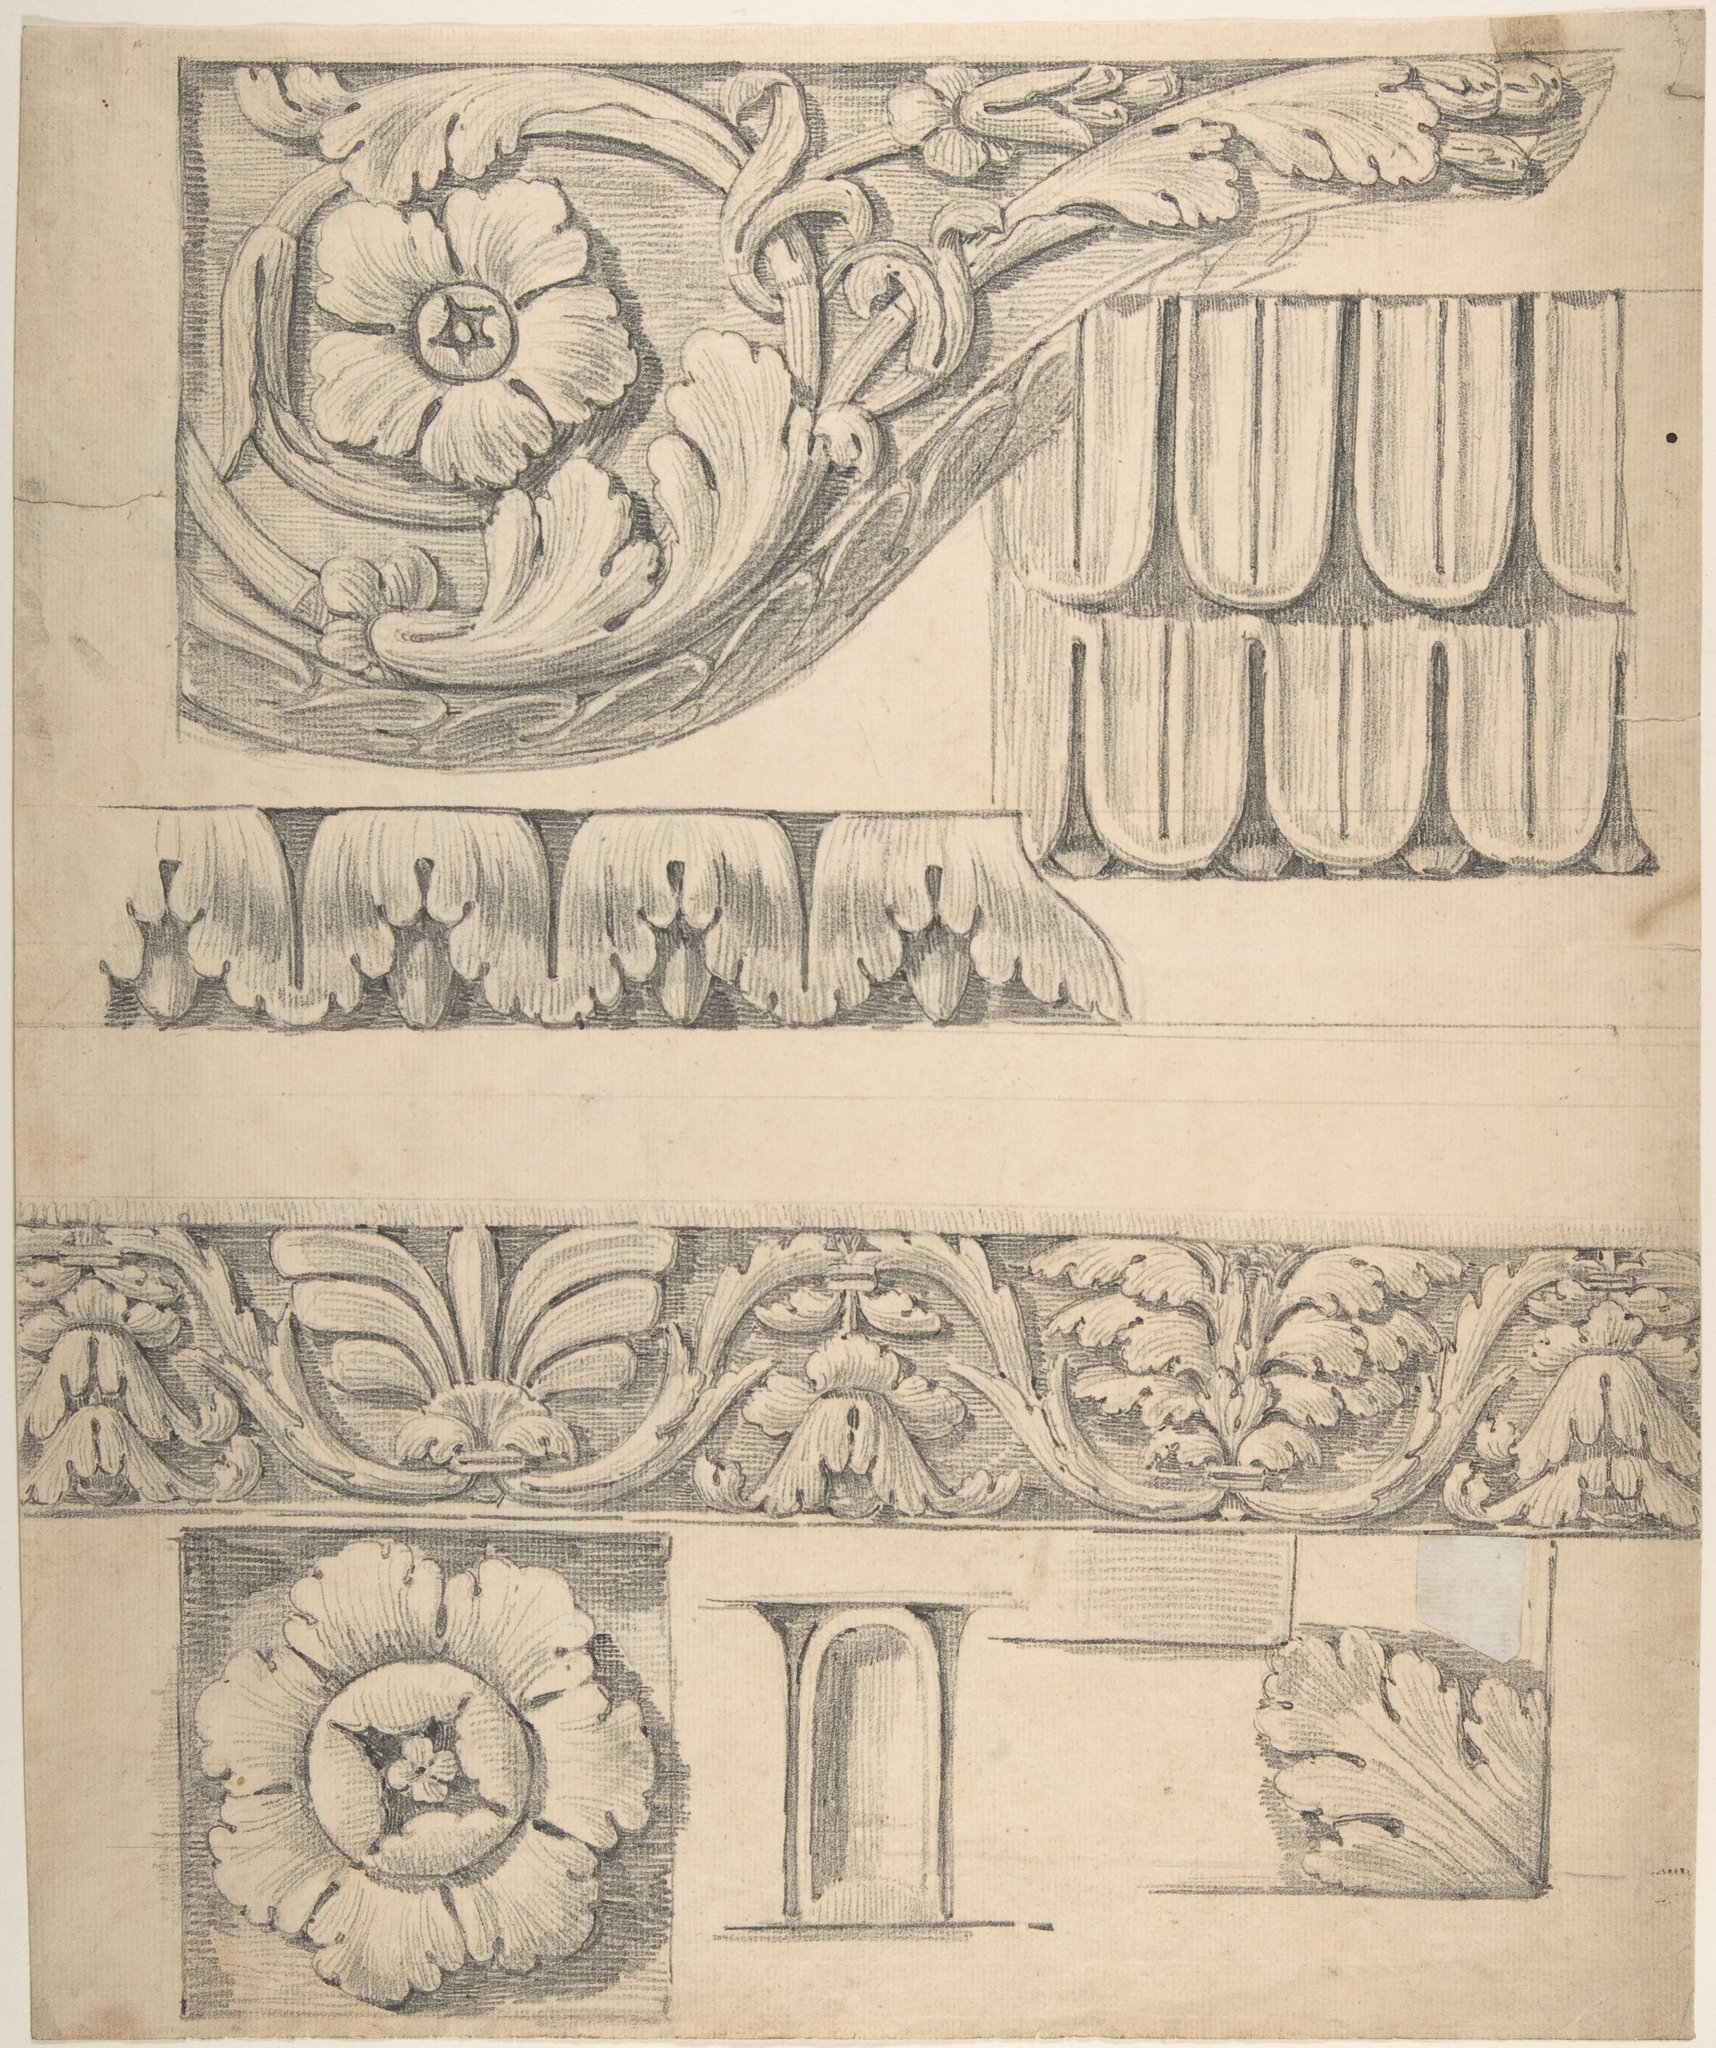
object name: drawing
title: Classical Border Elements with Vines and Leaves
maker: thomas hardwick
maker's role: artist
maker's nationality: british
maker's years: 1752-1829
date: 1776-1779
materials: graphite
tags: ornament